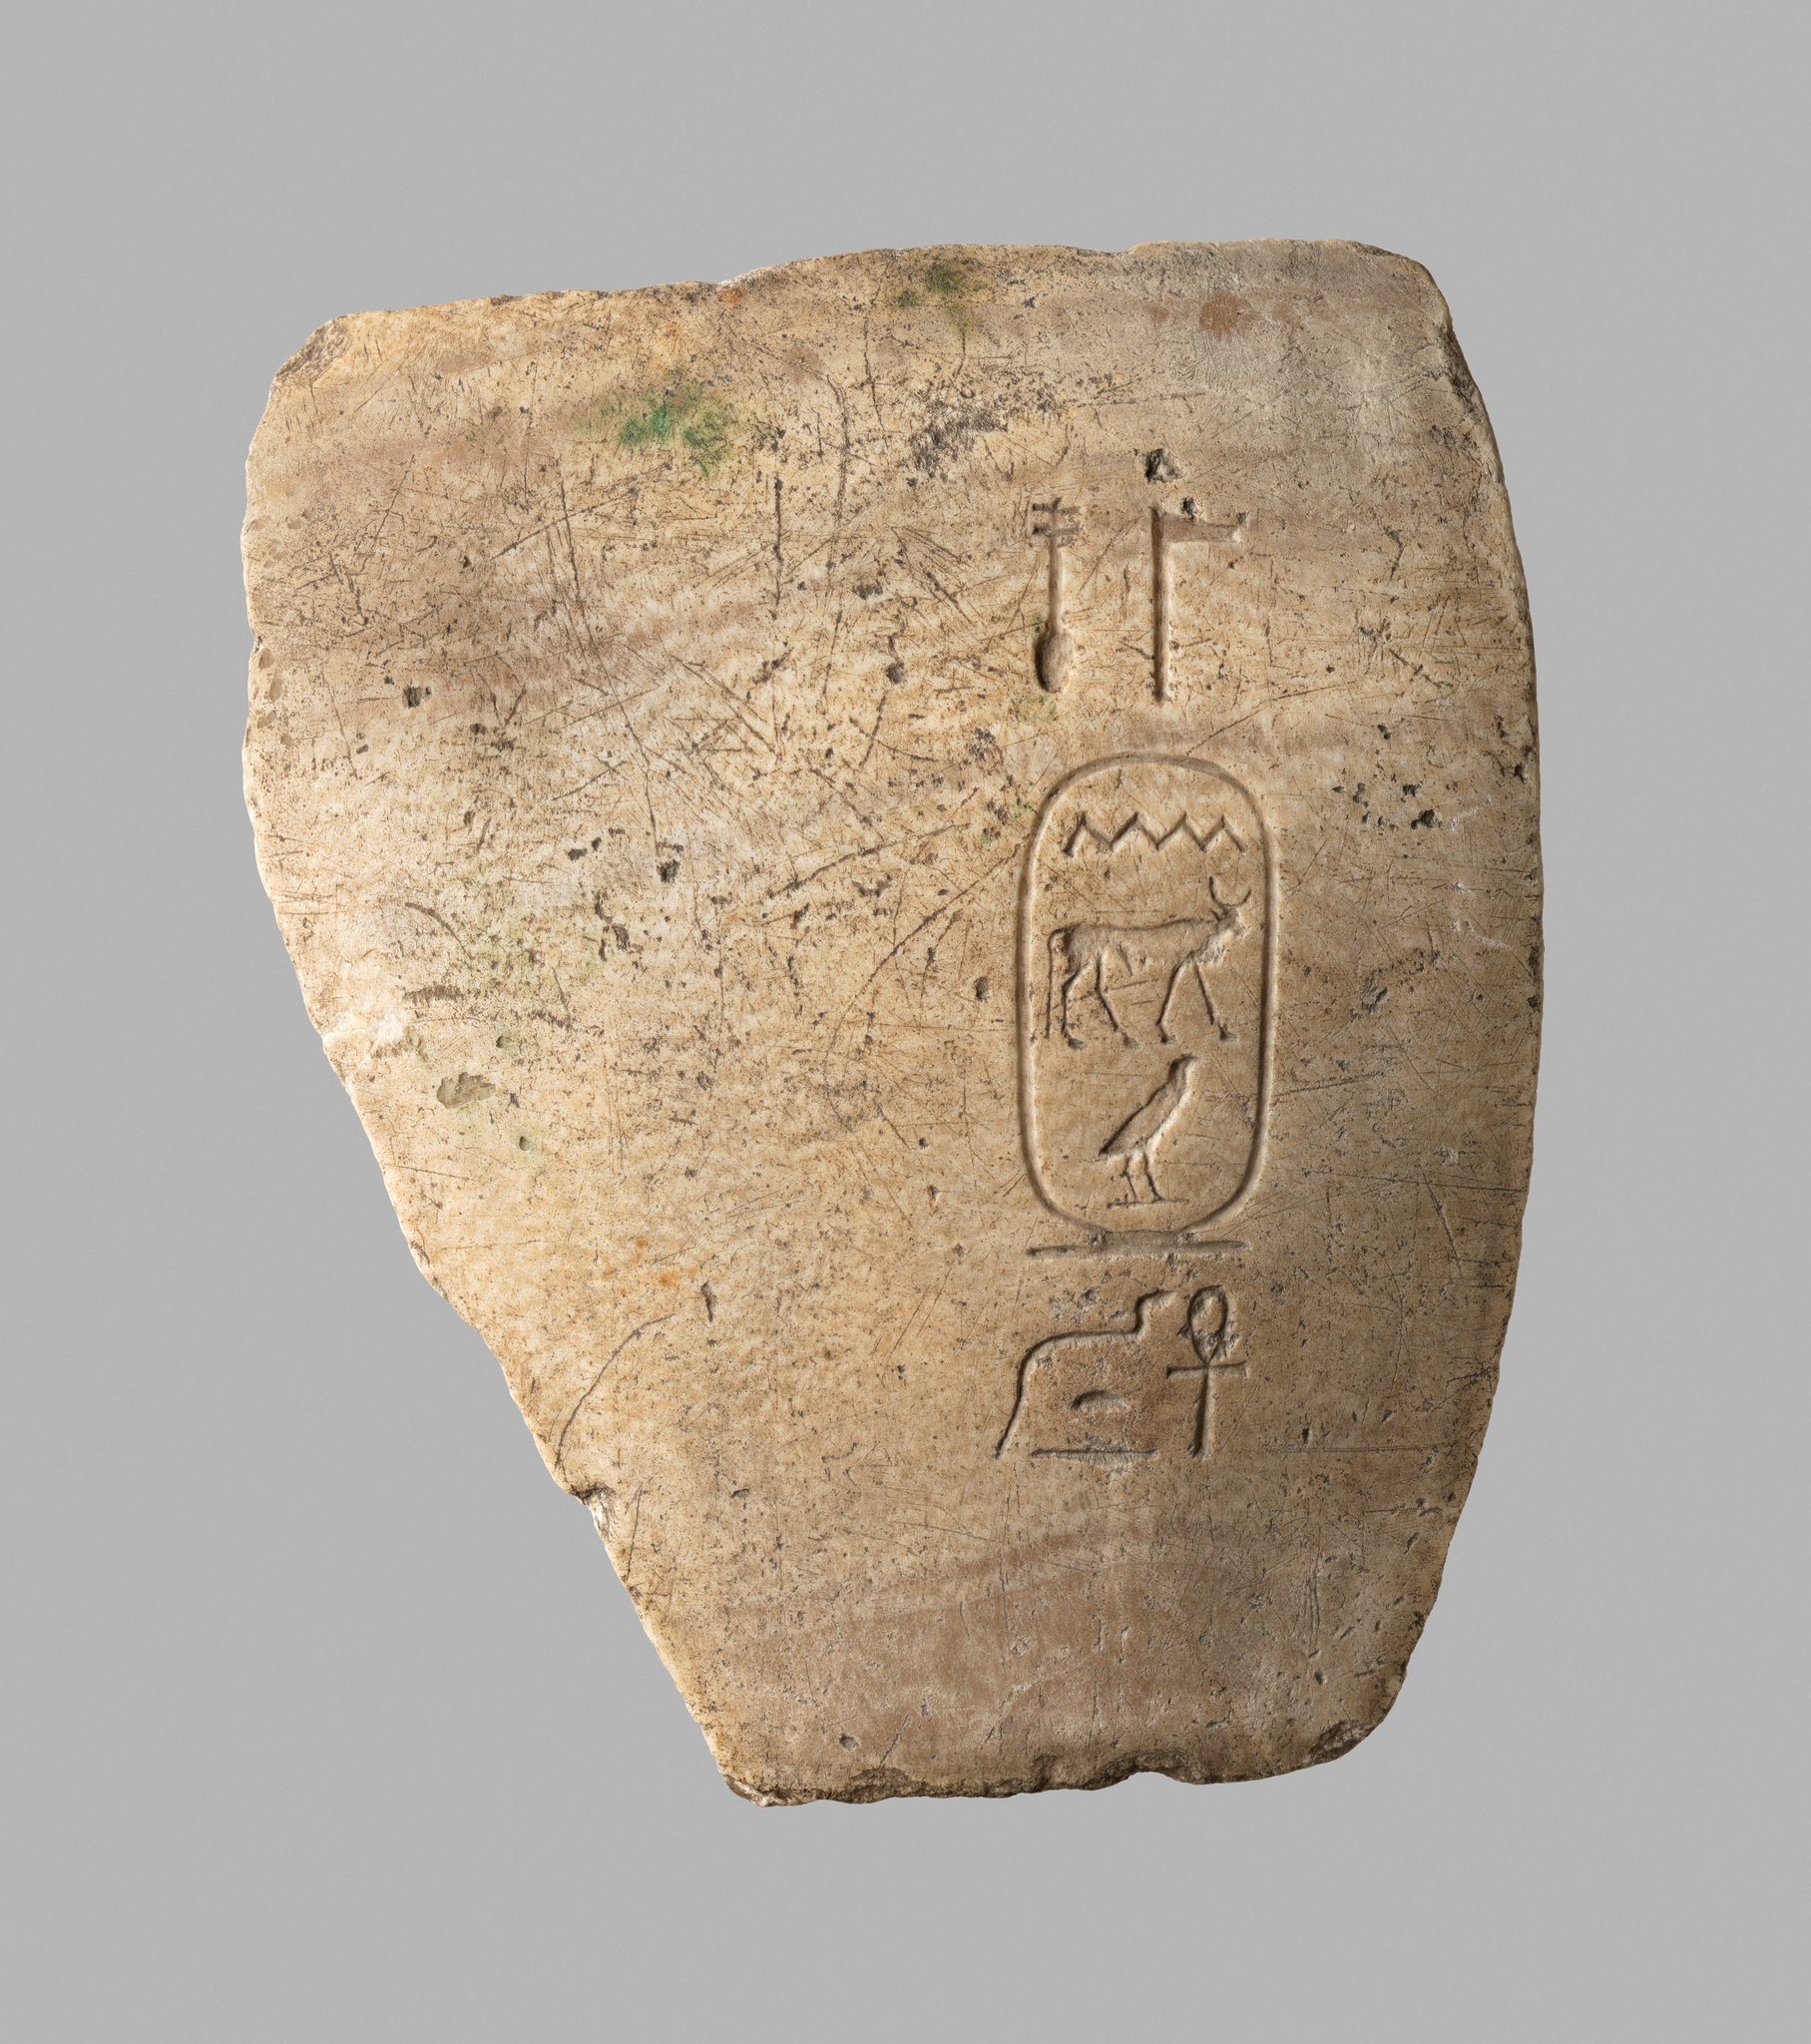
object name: vessel fragment, necho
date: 672-595 BCE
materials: stone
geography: egypt